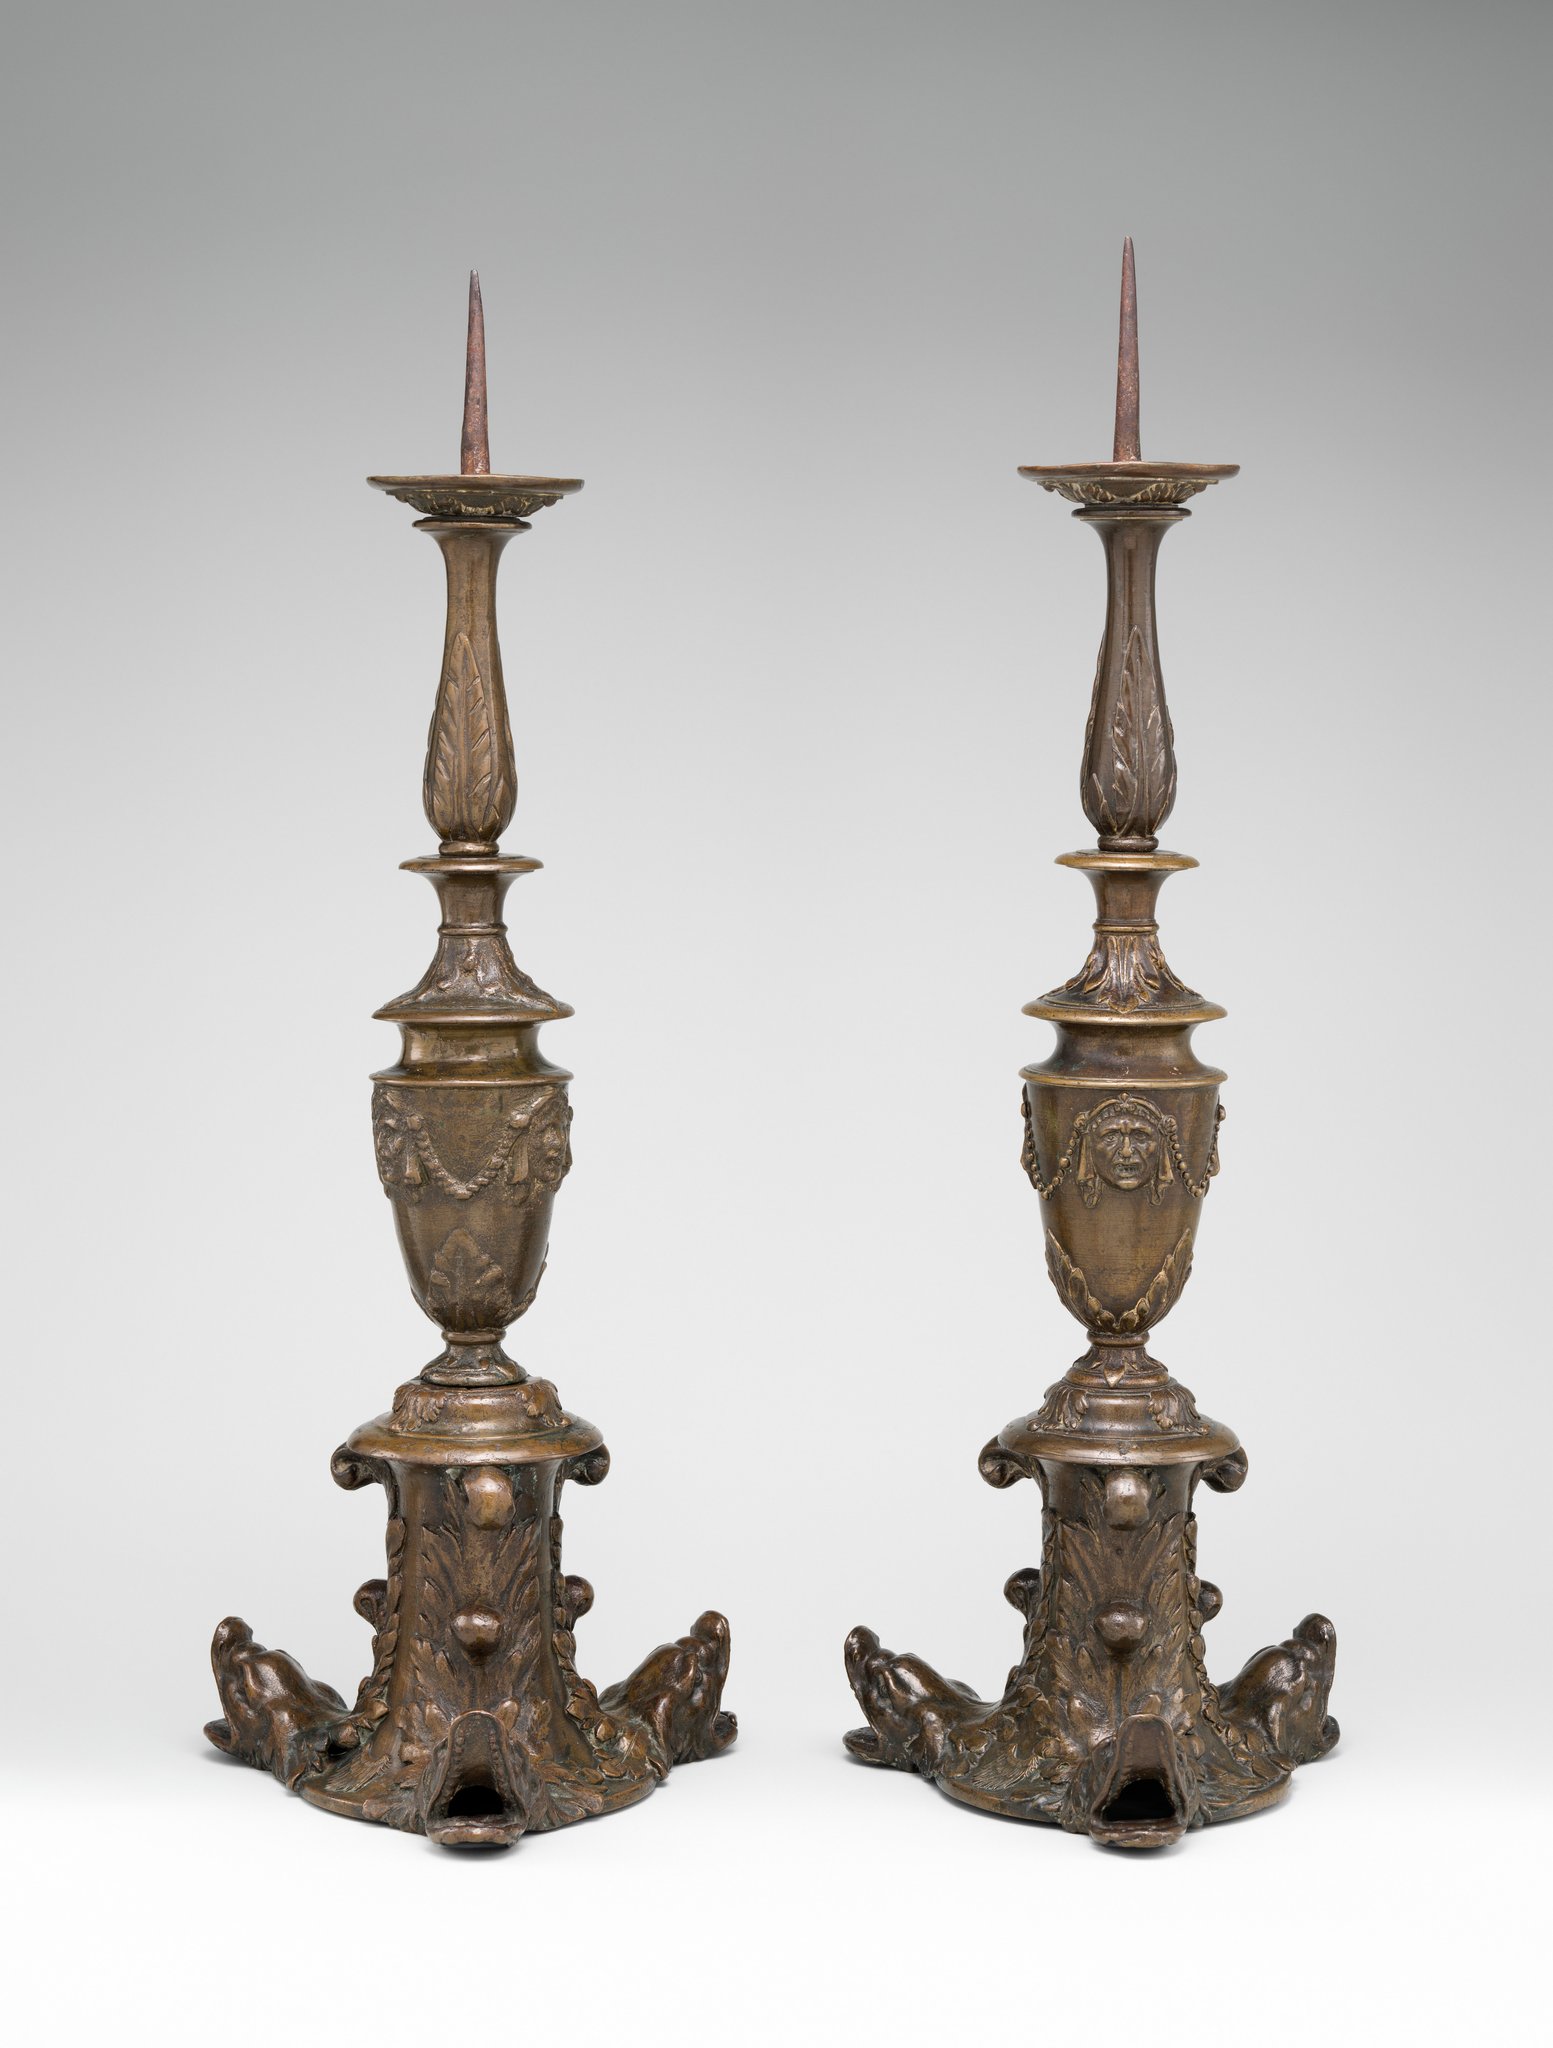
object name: candlestick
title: Pair of candlesticks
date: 1501-1600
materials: bronze